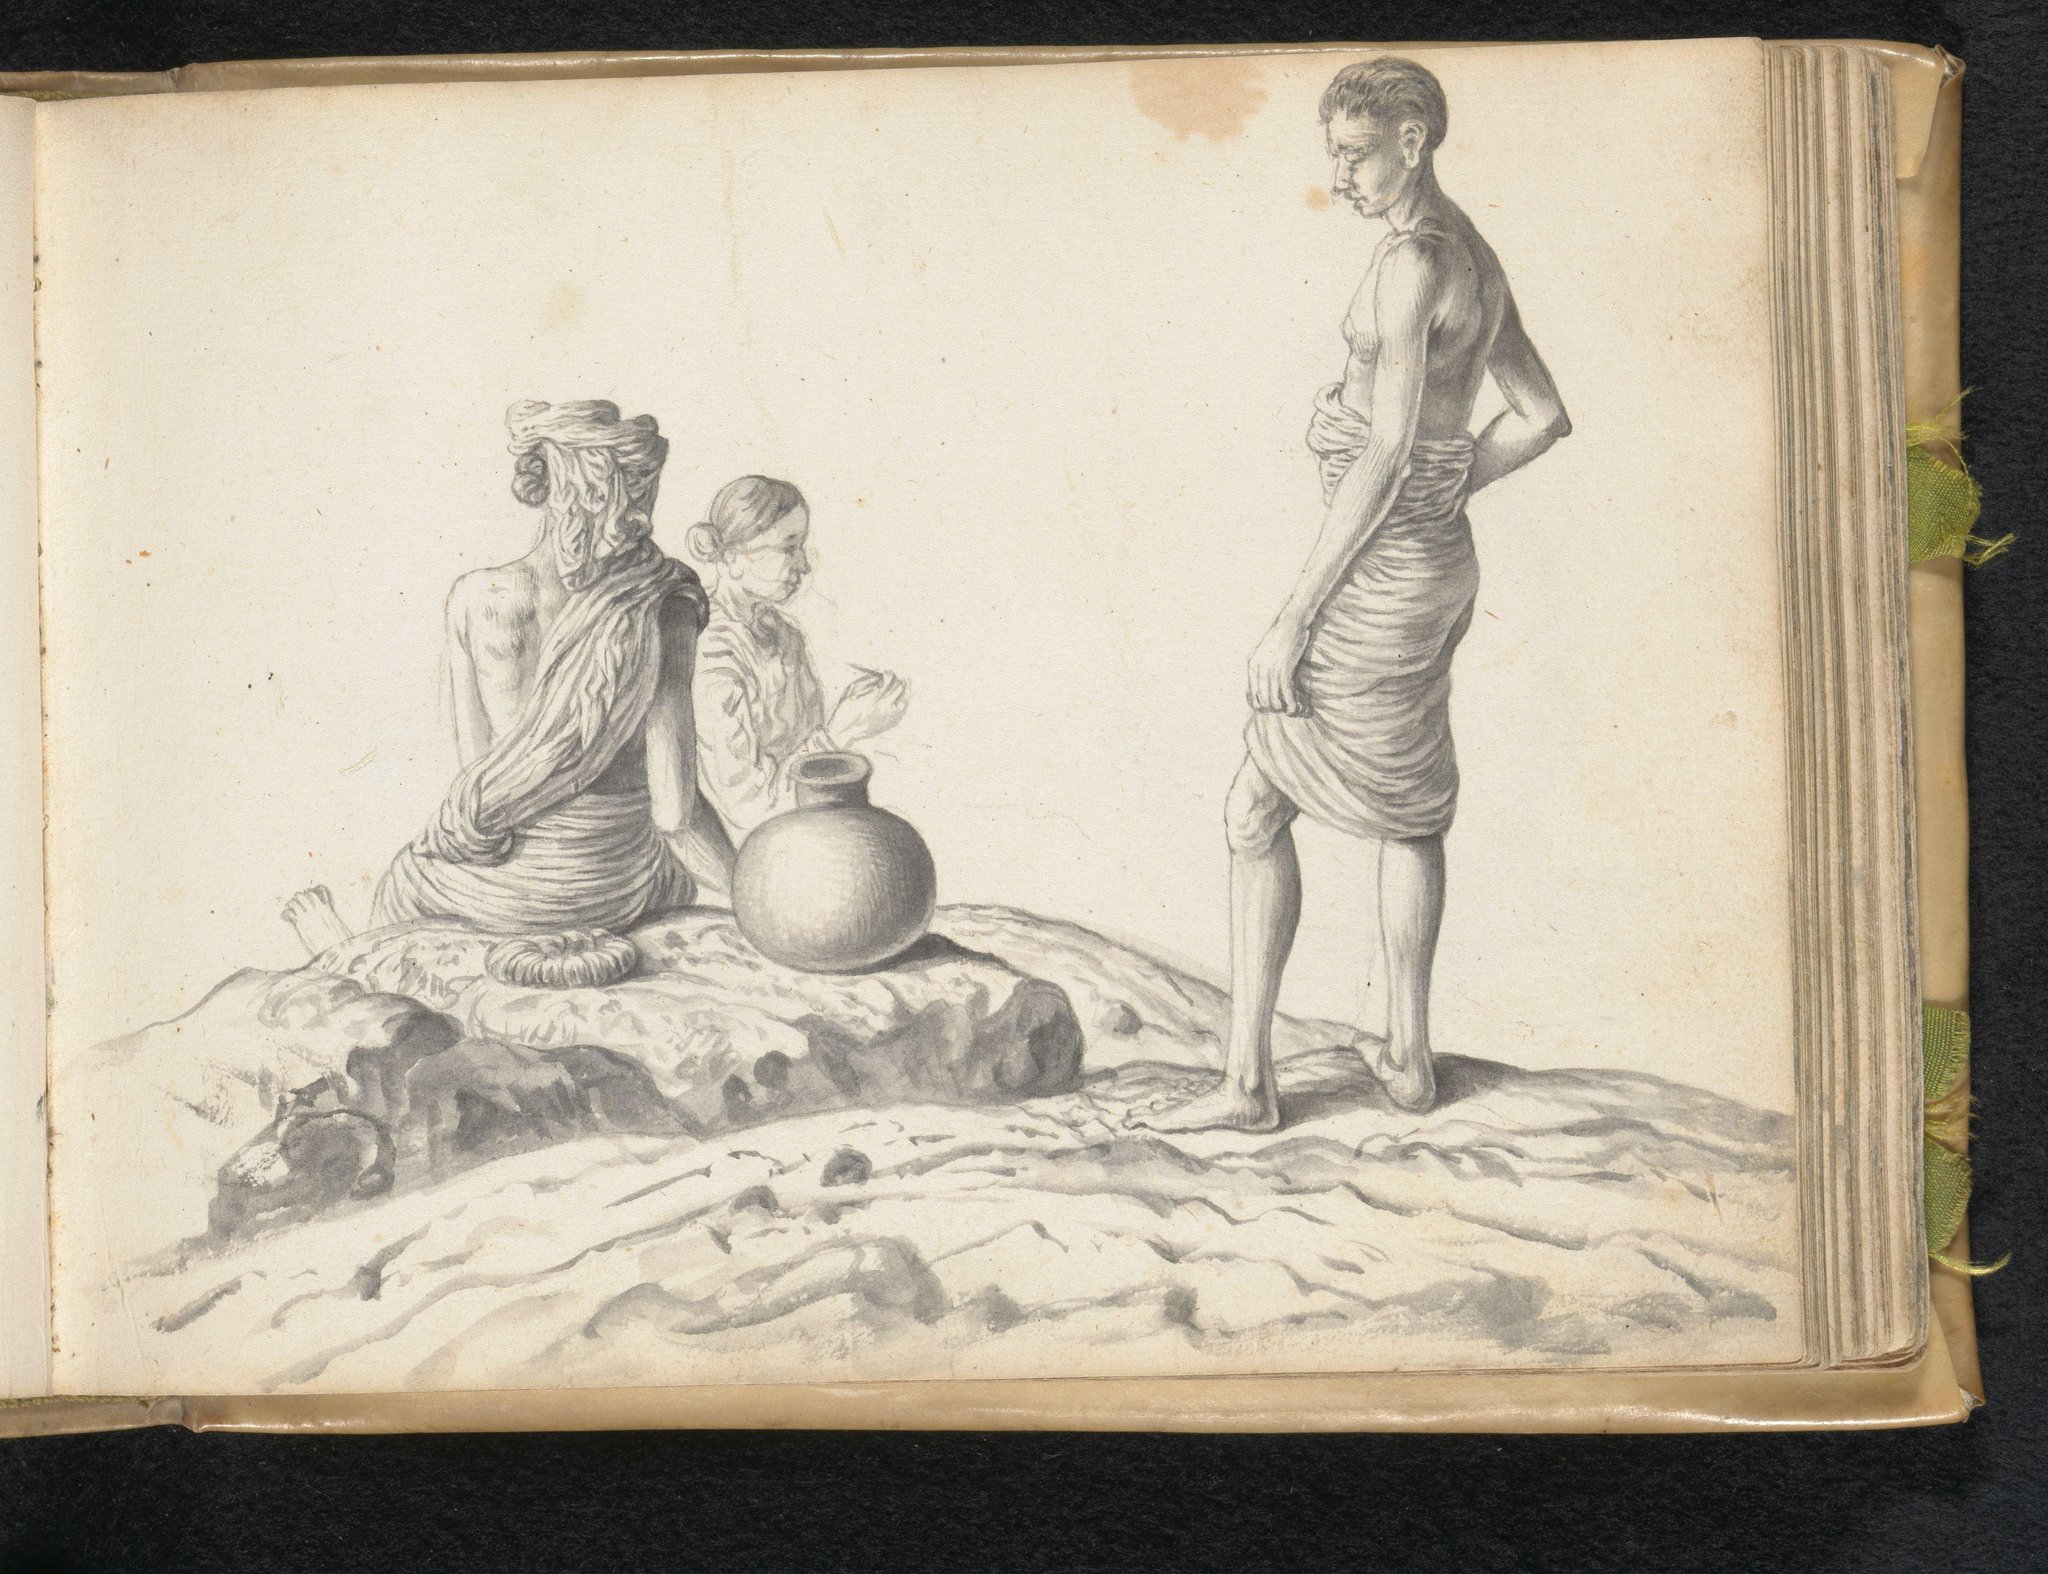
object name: sketchbook leaf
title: Two women and a man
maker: esaias boursse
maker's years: 1631-1672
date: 1662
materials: ink, paper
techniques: brush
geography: sri lanka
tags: asiatic races and peoples (srilankans), 41d232(...) skirt (lungi), asian races and peoples (with name), clothing for the upper part of the body (with name), clothes covering the entire body (with name), styles of hairdress (with name) - ~women, sri lanka